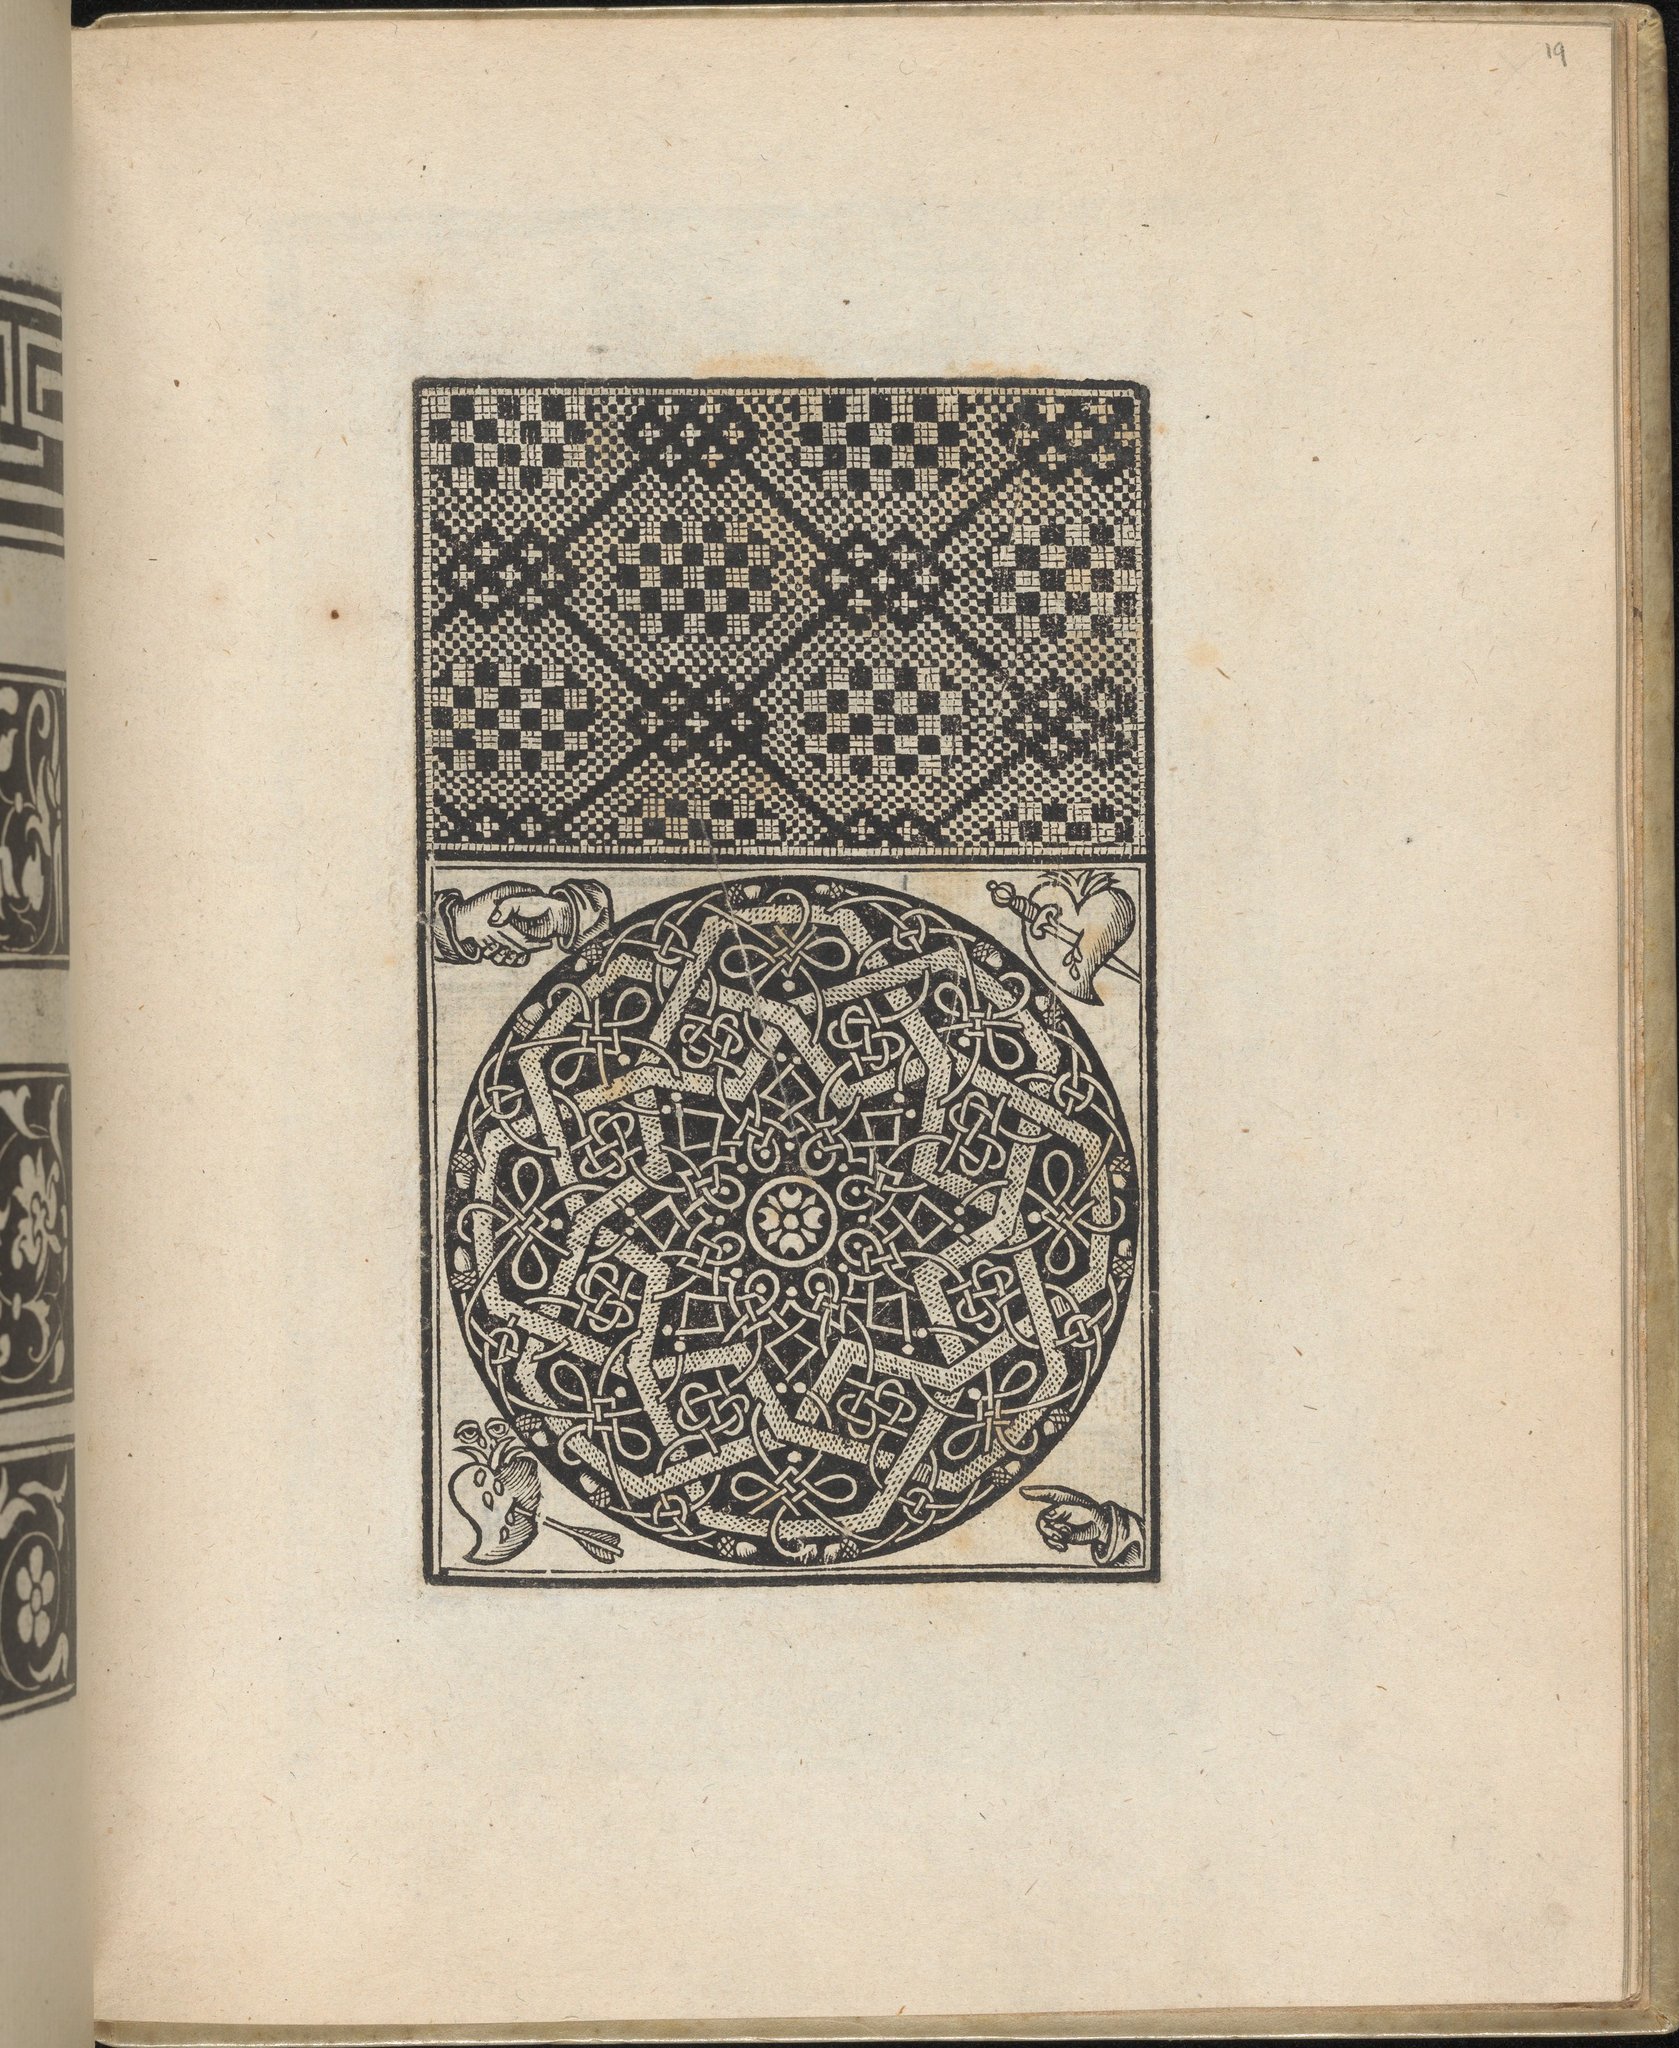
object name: book print ornament architecture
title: Trionfo Di Virtu. Libro Novo..., page 19 (verso)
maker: matteo pagano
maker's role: publisher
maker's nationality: italian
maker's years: 1515-1588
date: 1563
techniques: woodcut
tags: ornament